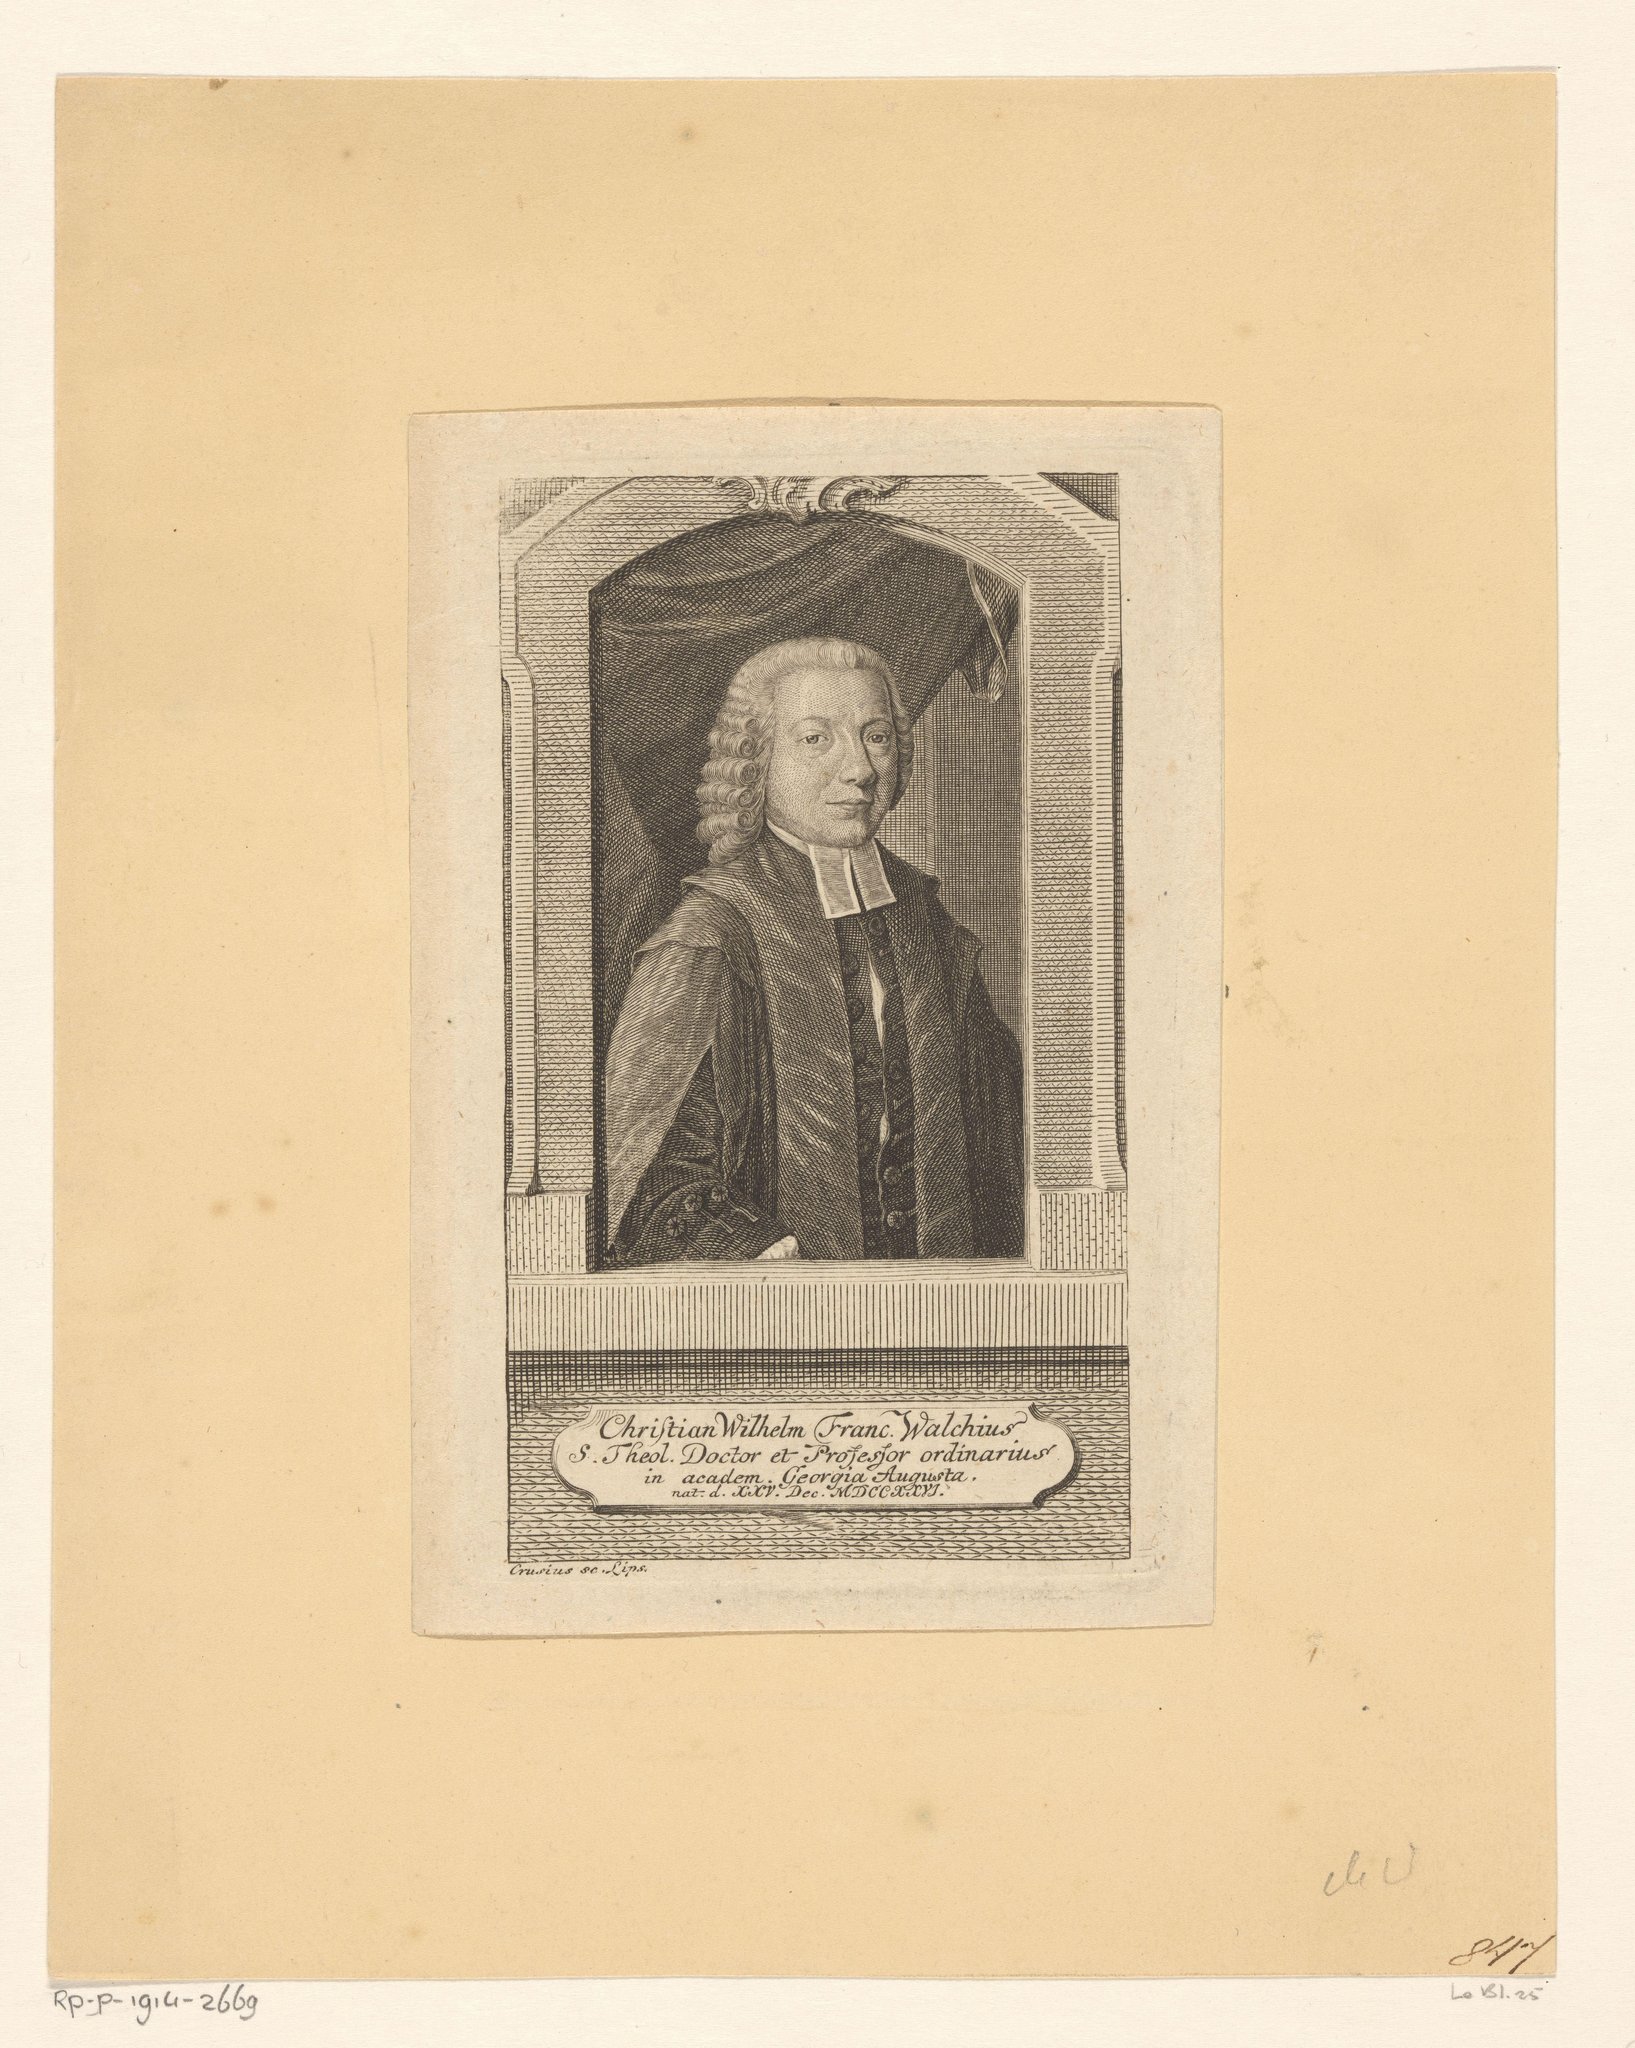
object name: print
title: Portret van Christian Wilhelm Franz Walch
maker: gottlieb leberecht crusius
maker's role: print maker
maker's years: 1730-1804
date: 1740-1784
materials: paper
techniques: engraving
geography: leipzig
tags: historical persons